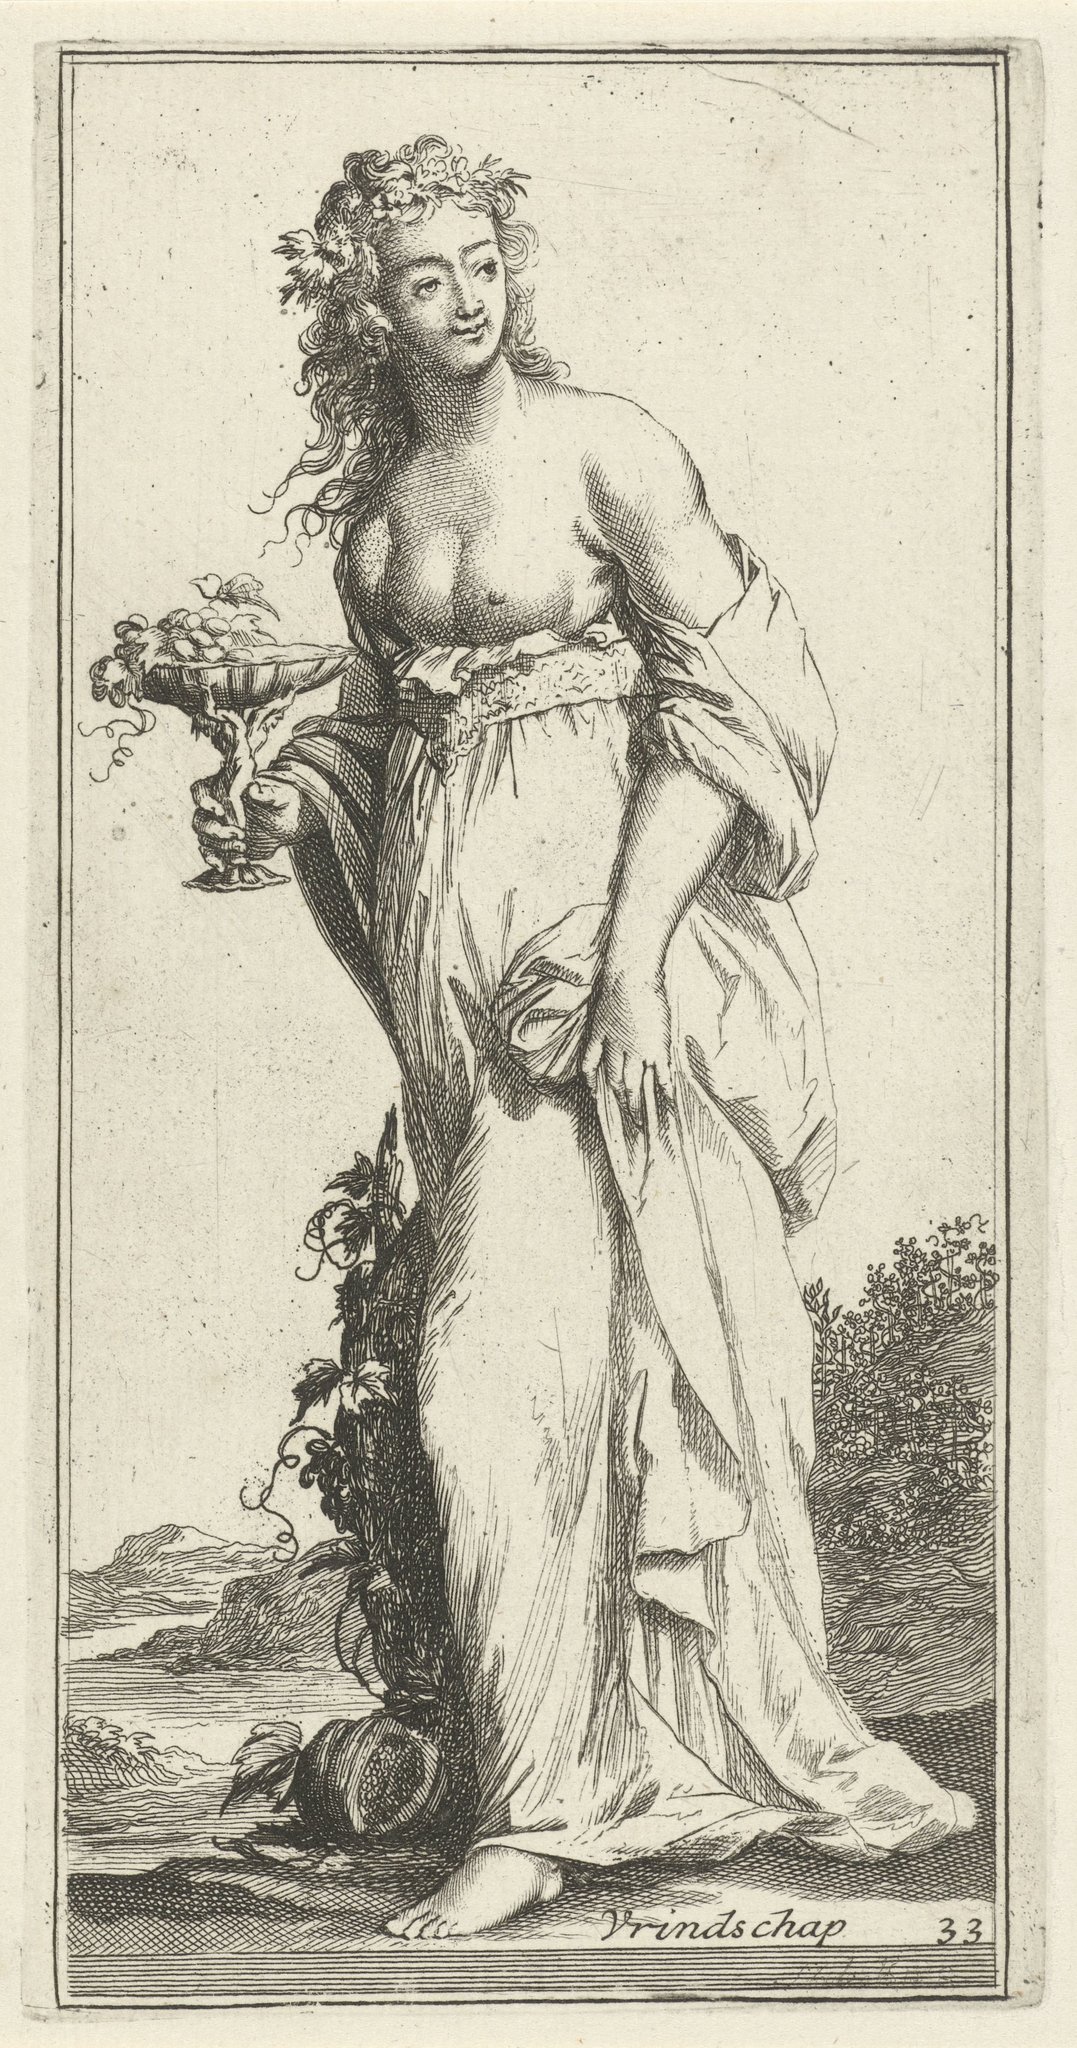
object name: print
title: Een-en-veertigh stuks, verscheydene Sinnebeelden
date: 1710-1719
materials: paper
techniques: engraving, etching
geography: amsterdam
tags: friendship; 'amicitia' (ripa), bowl, fruits: pumpkin, grape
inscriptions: collector's mark: Lugt 2228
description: Een vrouwfiguur als personificatie van vriendschap, met in haar hand een schaal met druiven. Op de grond bij haar voet een pompoen. Prent uit een serie van 41 zinnebeelden.